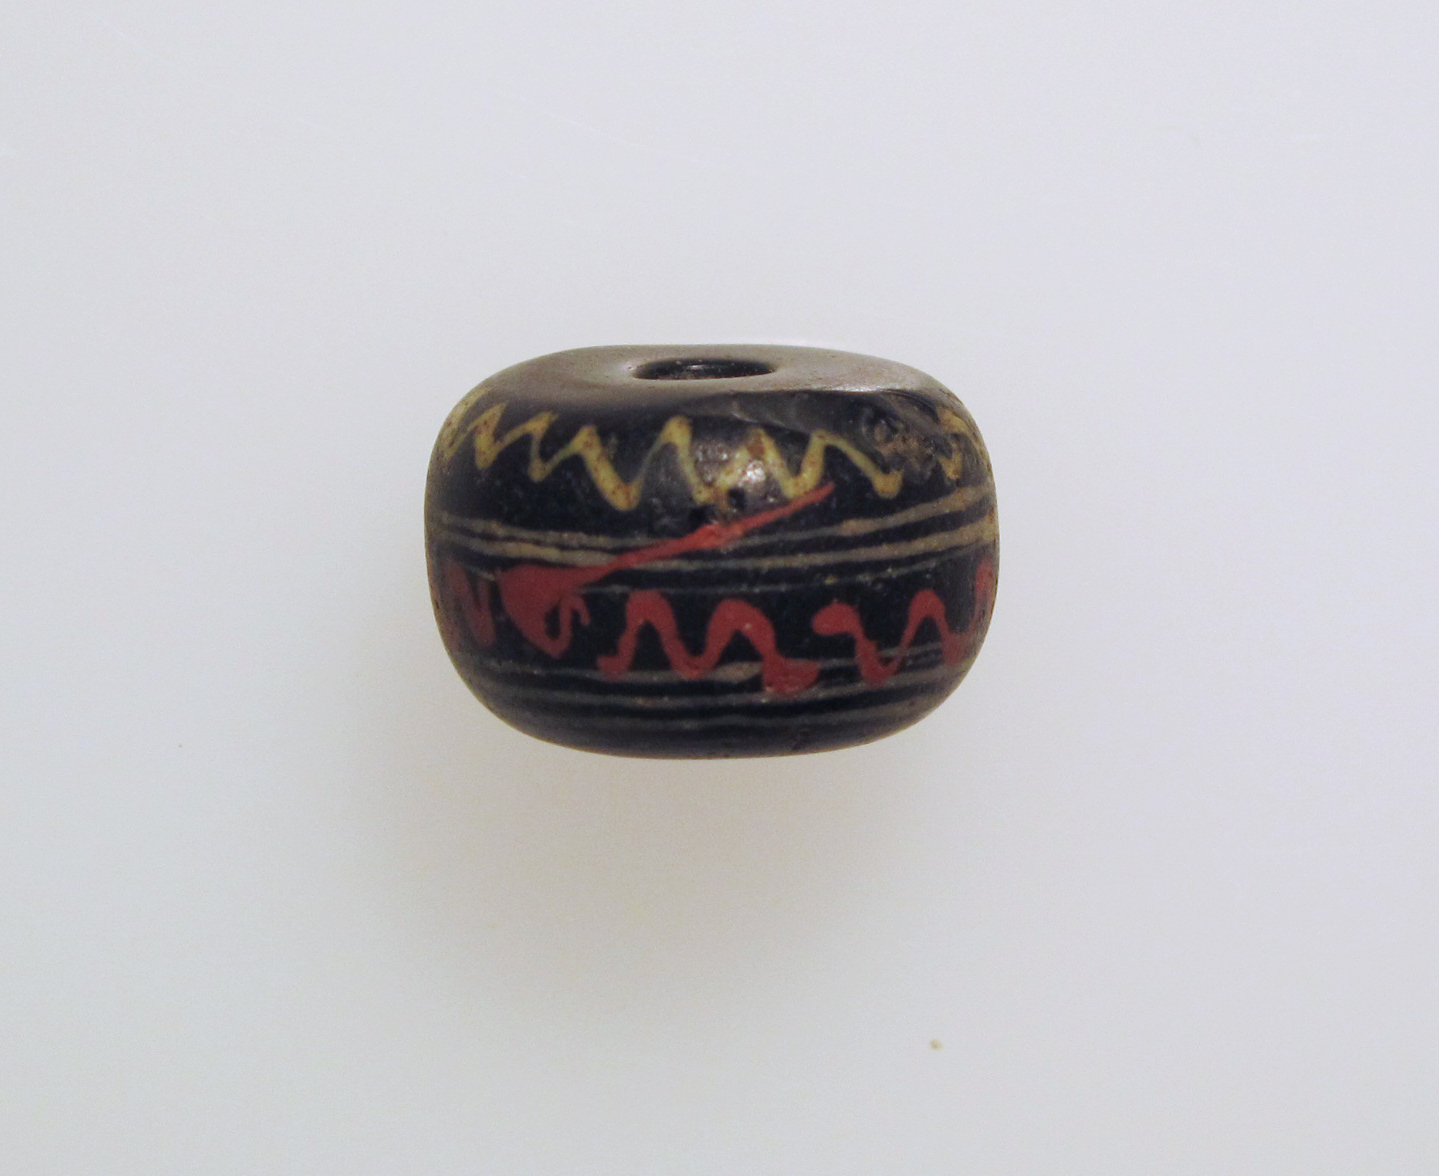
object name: bead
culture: roman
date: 670 BCE-330 CE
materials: glass